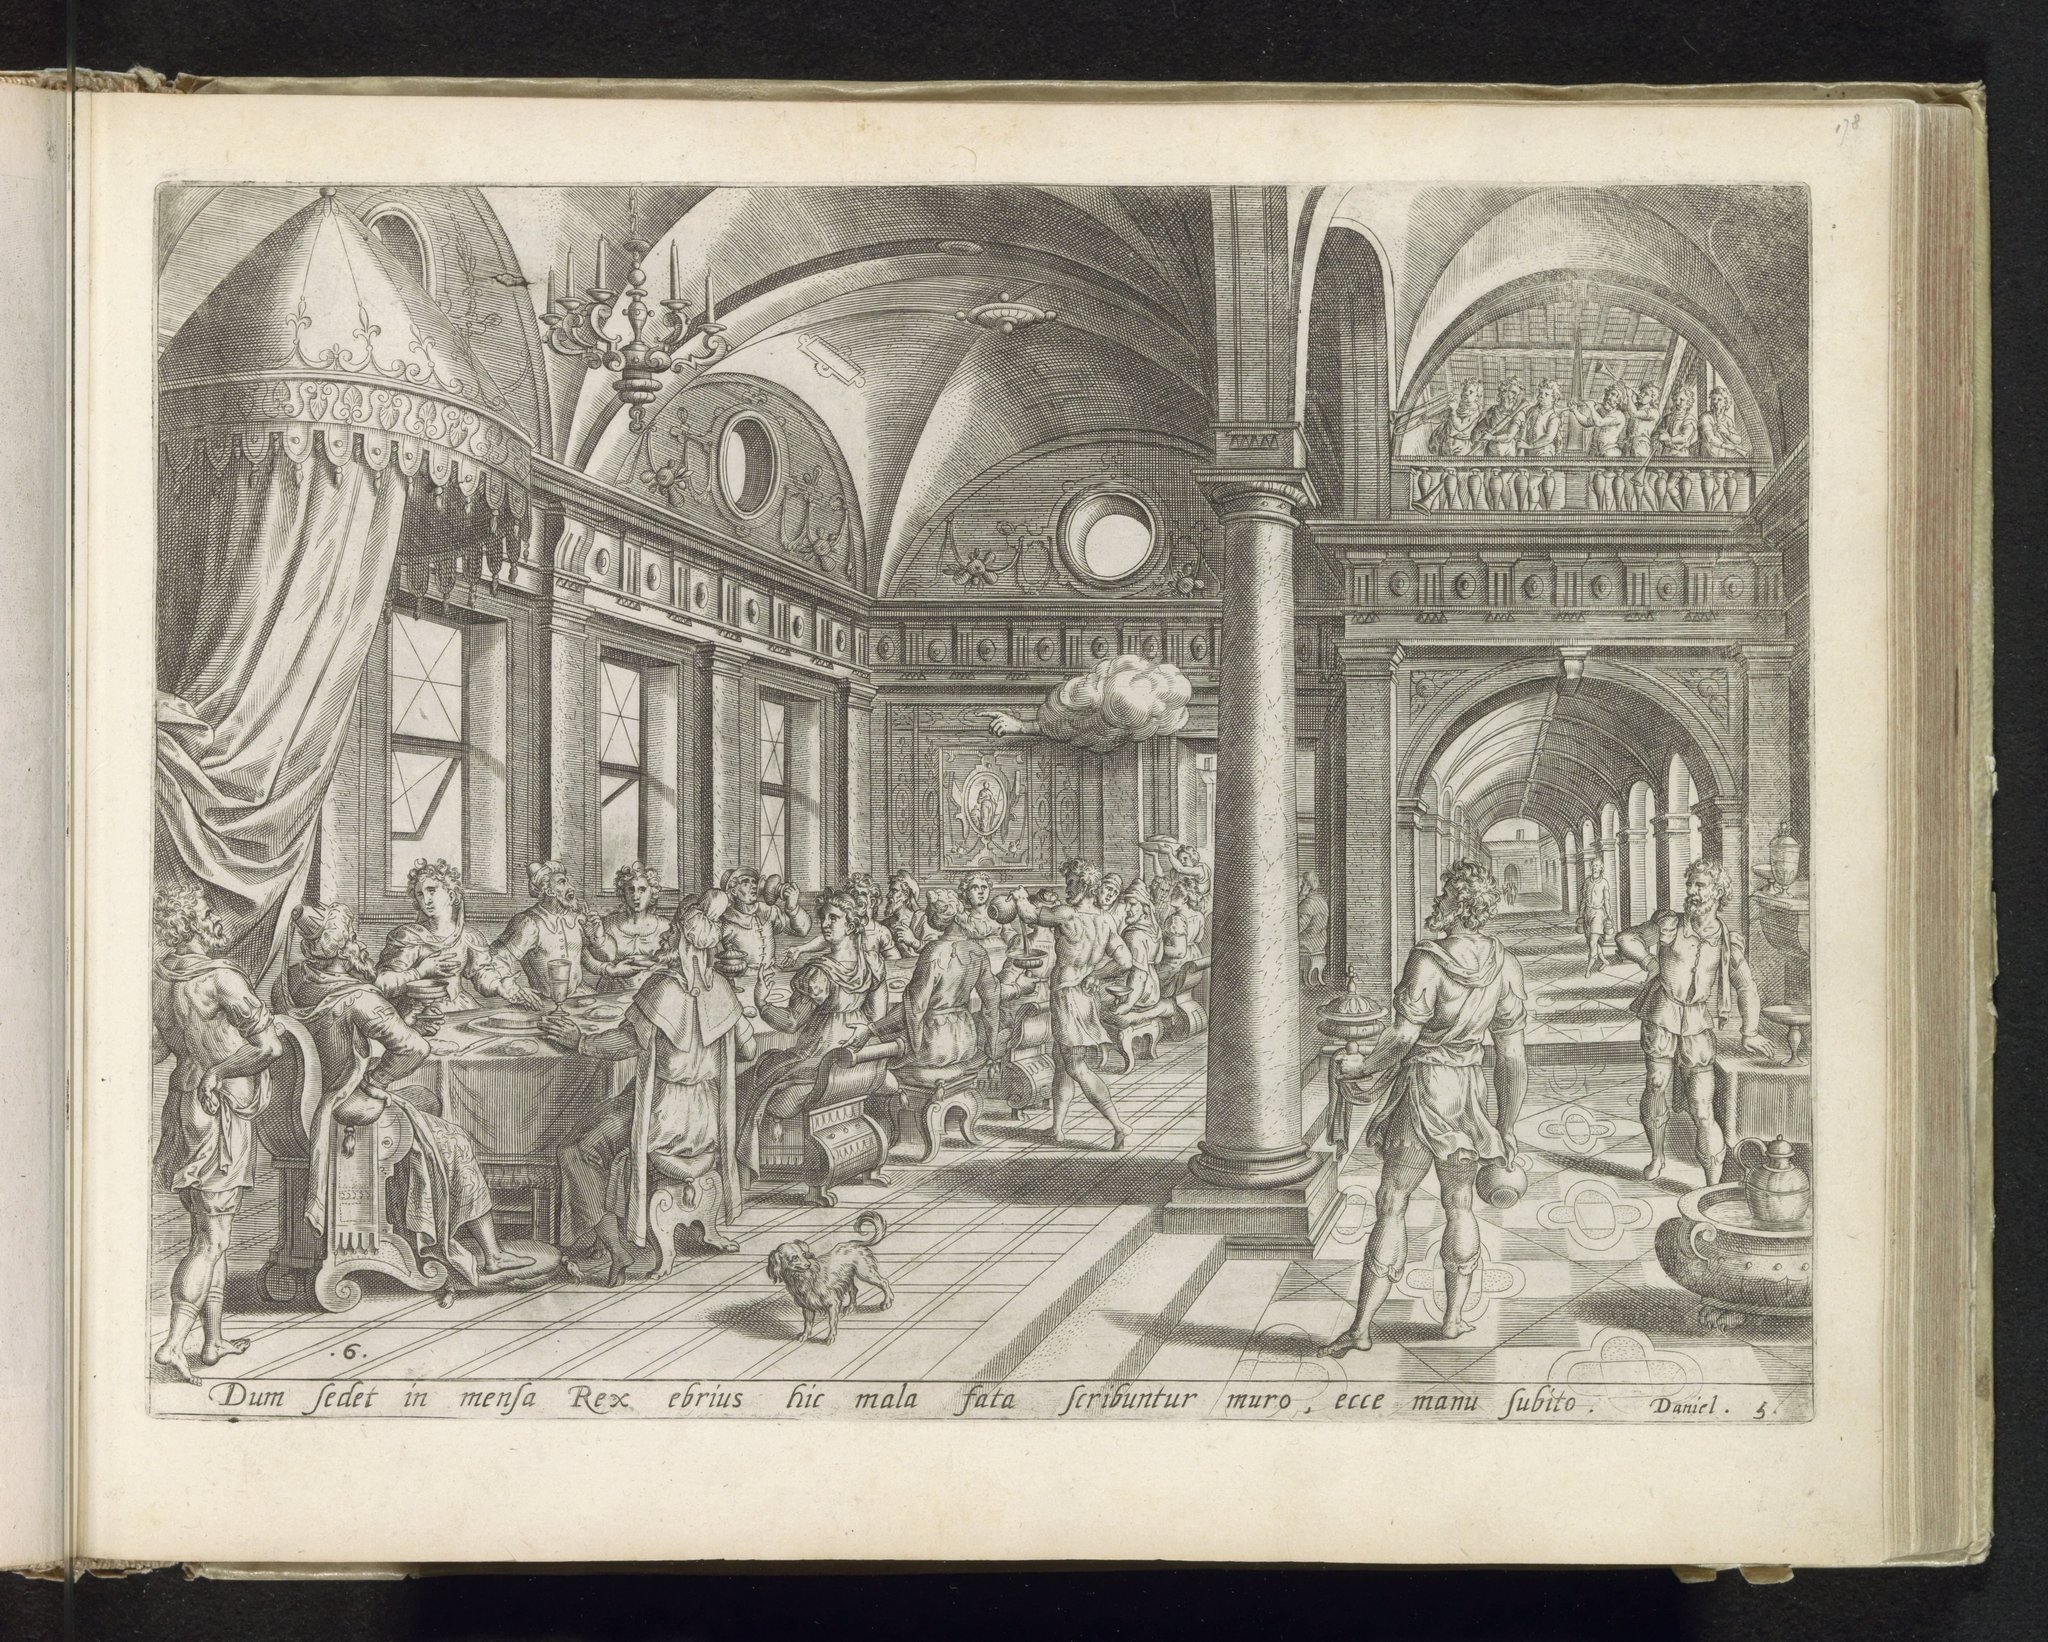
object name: album leaf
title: Geschiedenis van Daniël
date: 1585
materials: paper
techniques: engraving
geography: antwerp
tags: during belshazzar's banquet a hand appears and writes on the wall (mene, mene, tekel and parsin (upharsin)); king belshazzar is frightened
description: Het feestmaal van Belsassar, koning van Babylon, met zijn hovelingen en vrouwen. Belsassar, op de rug gezien aan het hoofd van de tafel, ziet een schrijvende hand verschijnen. Op tafel staan de gestolen bekers en schalen uit de tempel van Jeruzalem. Rechtsboven staan trompetters op het balkon. Onder de voorstelling een verwijzing in het Latijn naar de Bijbeltekst in Dan. 5. Deze prent maakt deel uit van een album.